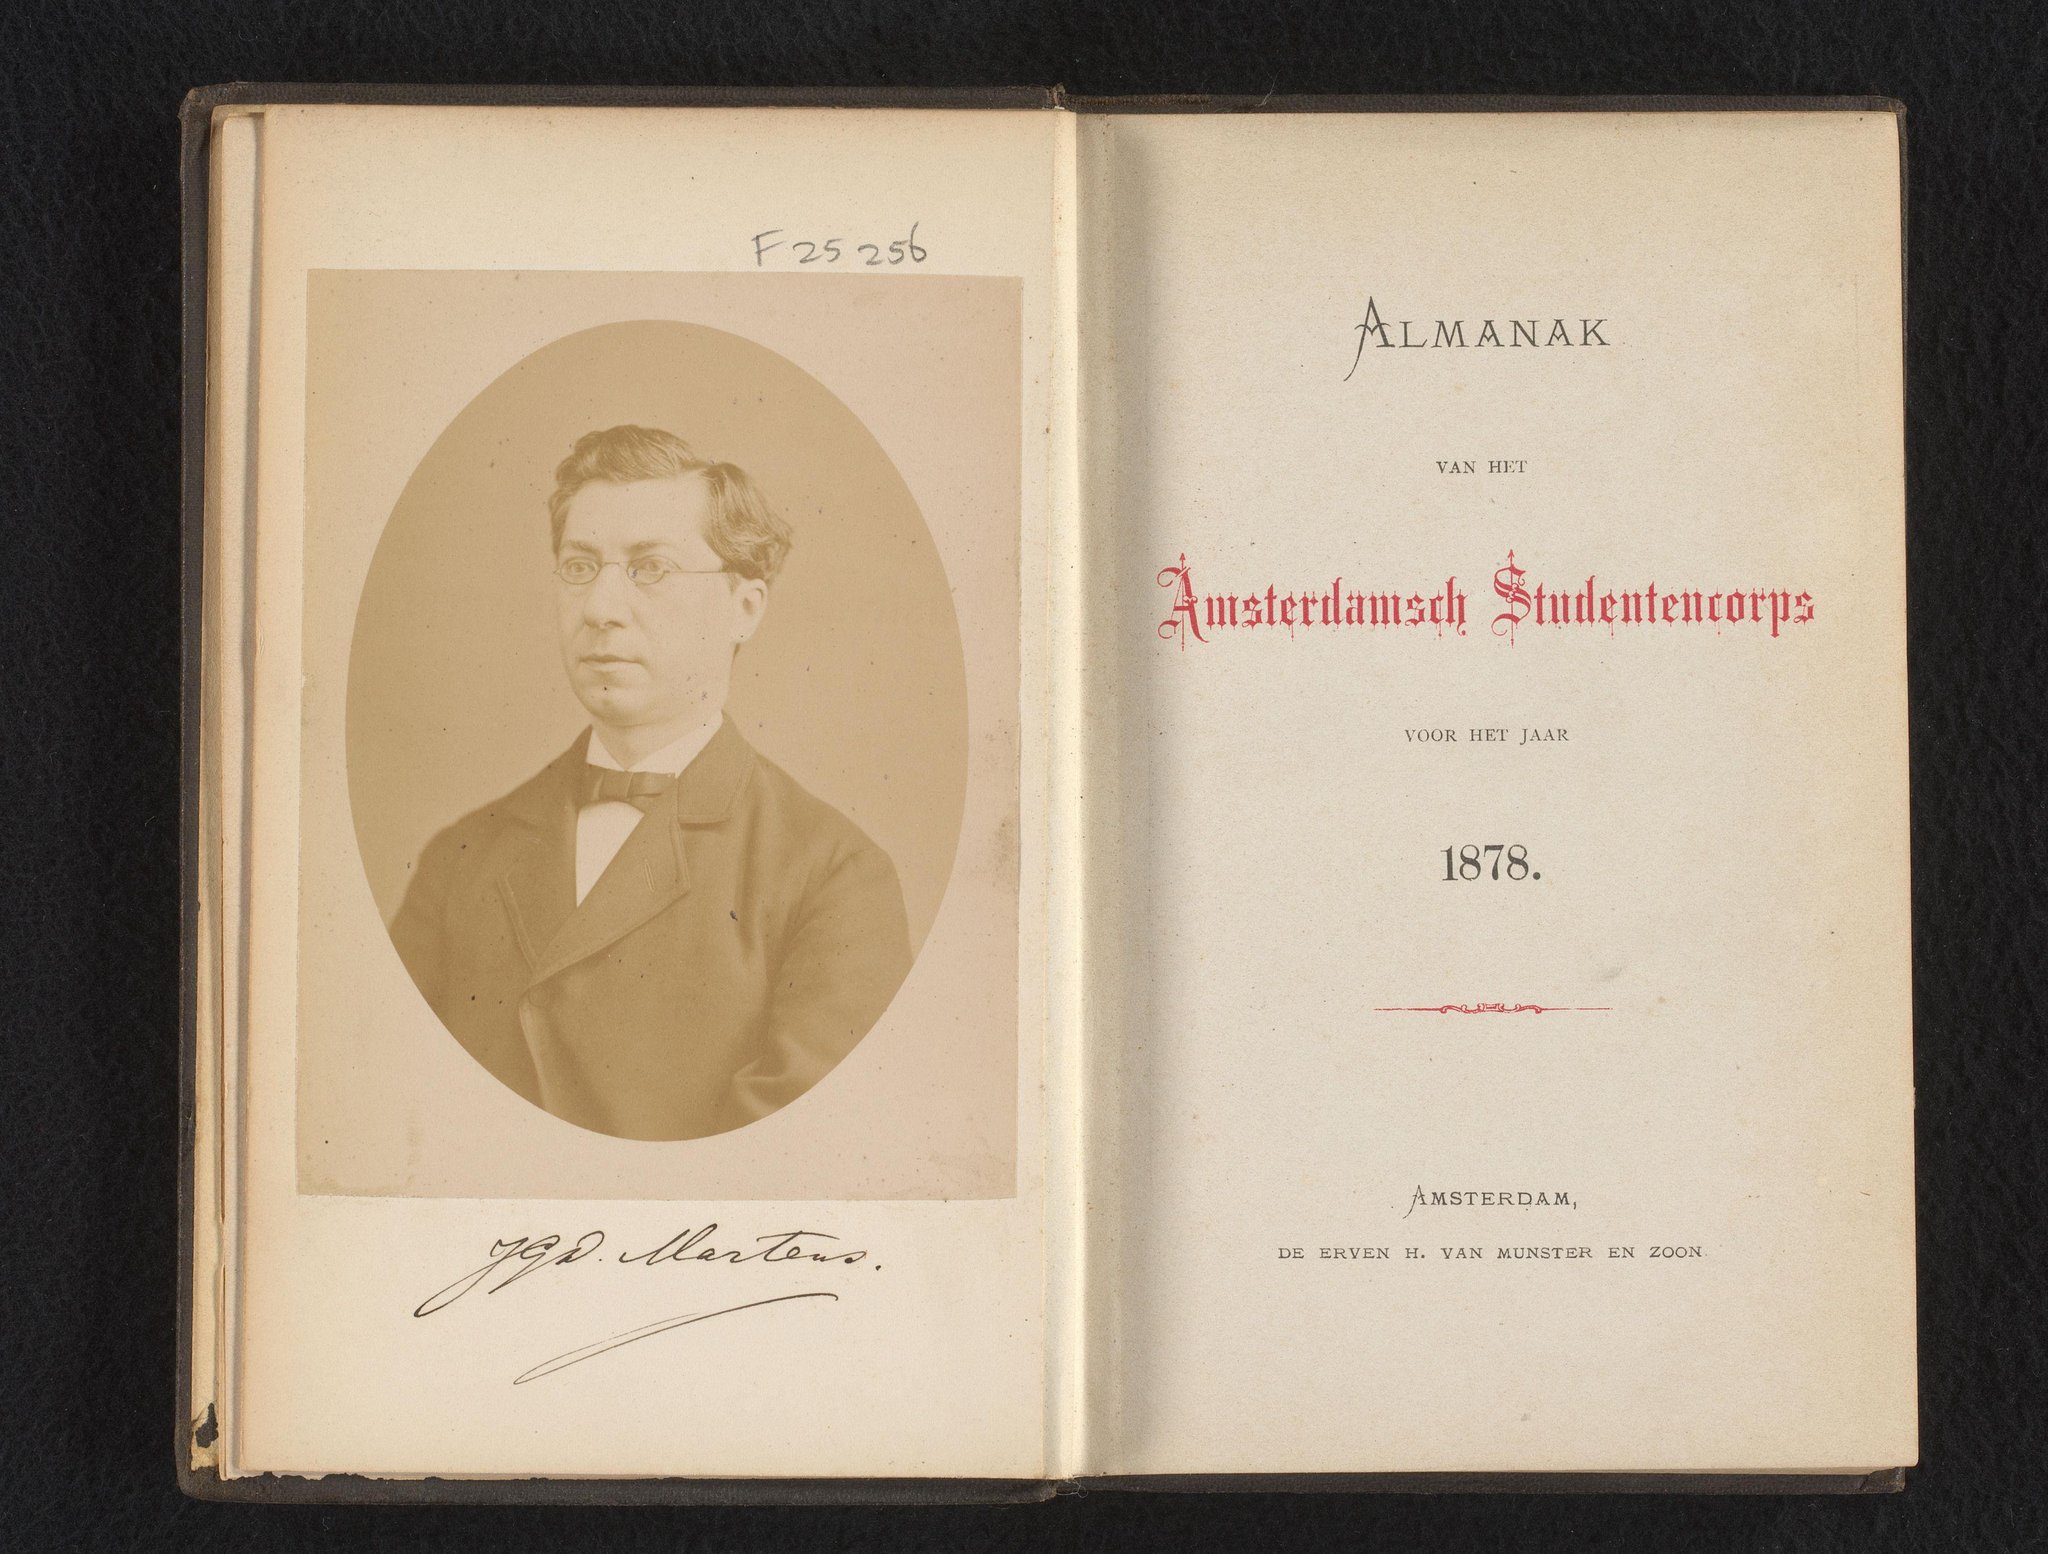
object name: page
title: Portret van J.G.D. Martens, hoogleraar godgeleerdheid aan de Universiteit van Amsterdam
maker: gustaaf leonardus adolf amand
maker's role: print maker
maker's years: 1833-1897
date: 1877-1878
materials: paper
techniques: albumen print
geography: amsterdam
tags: amsterdam, historical persons, professor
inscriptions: signature: ‘JGD Martens’